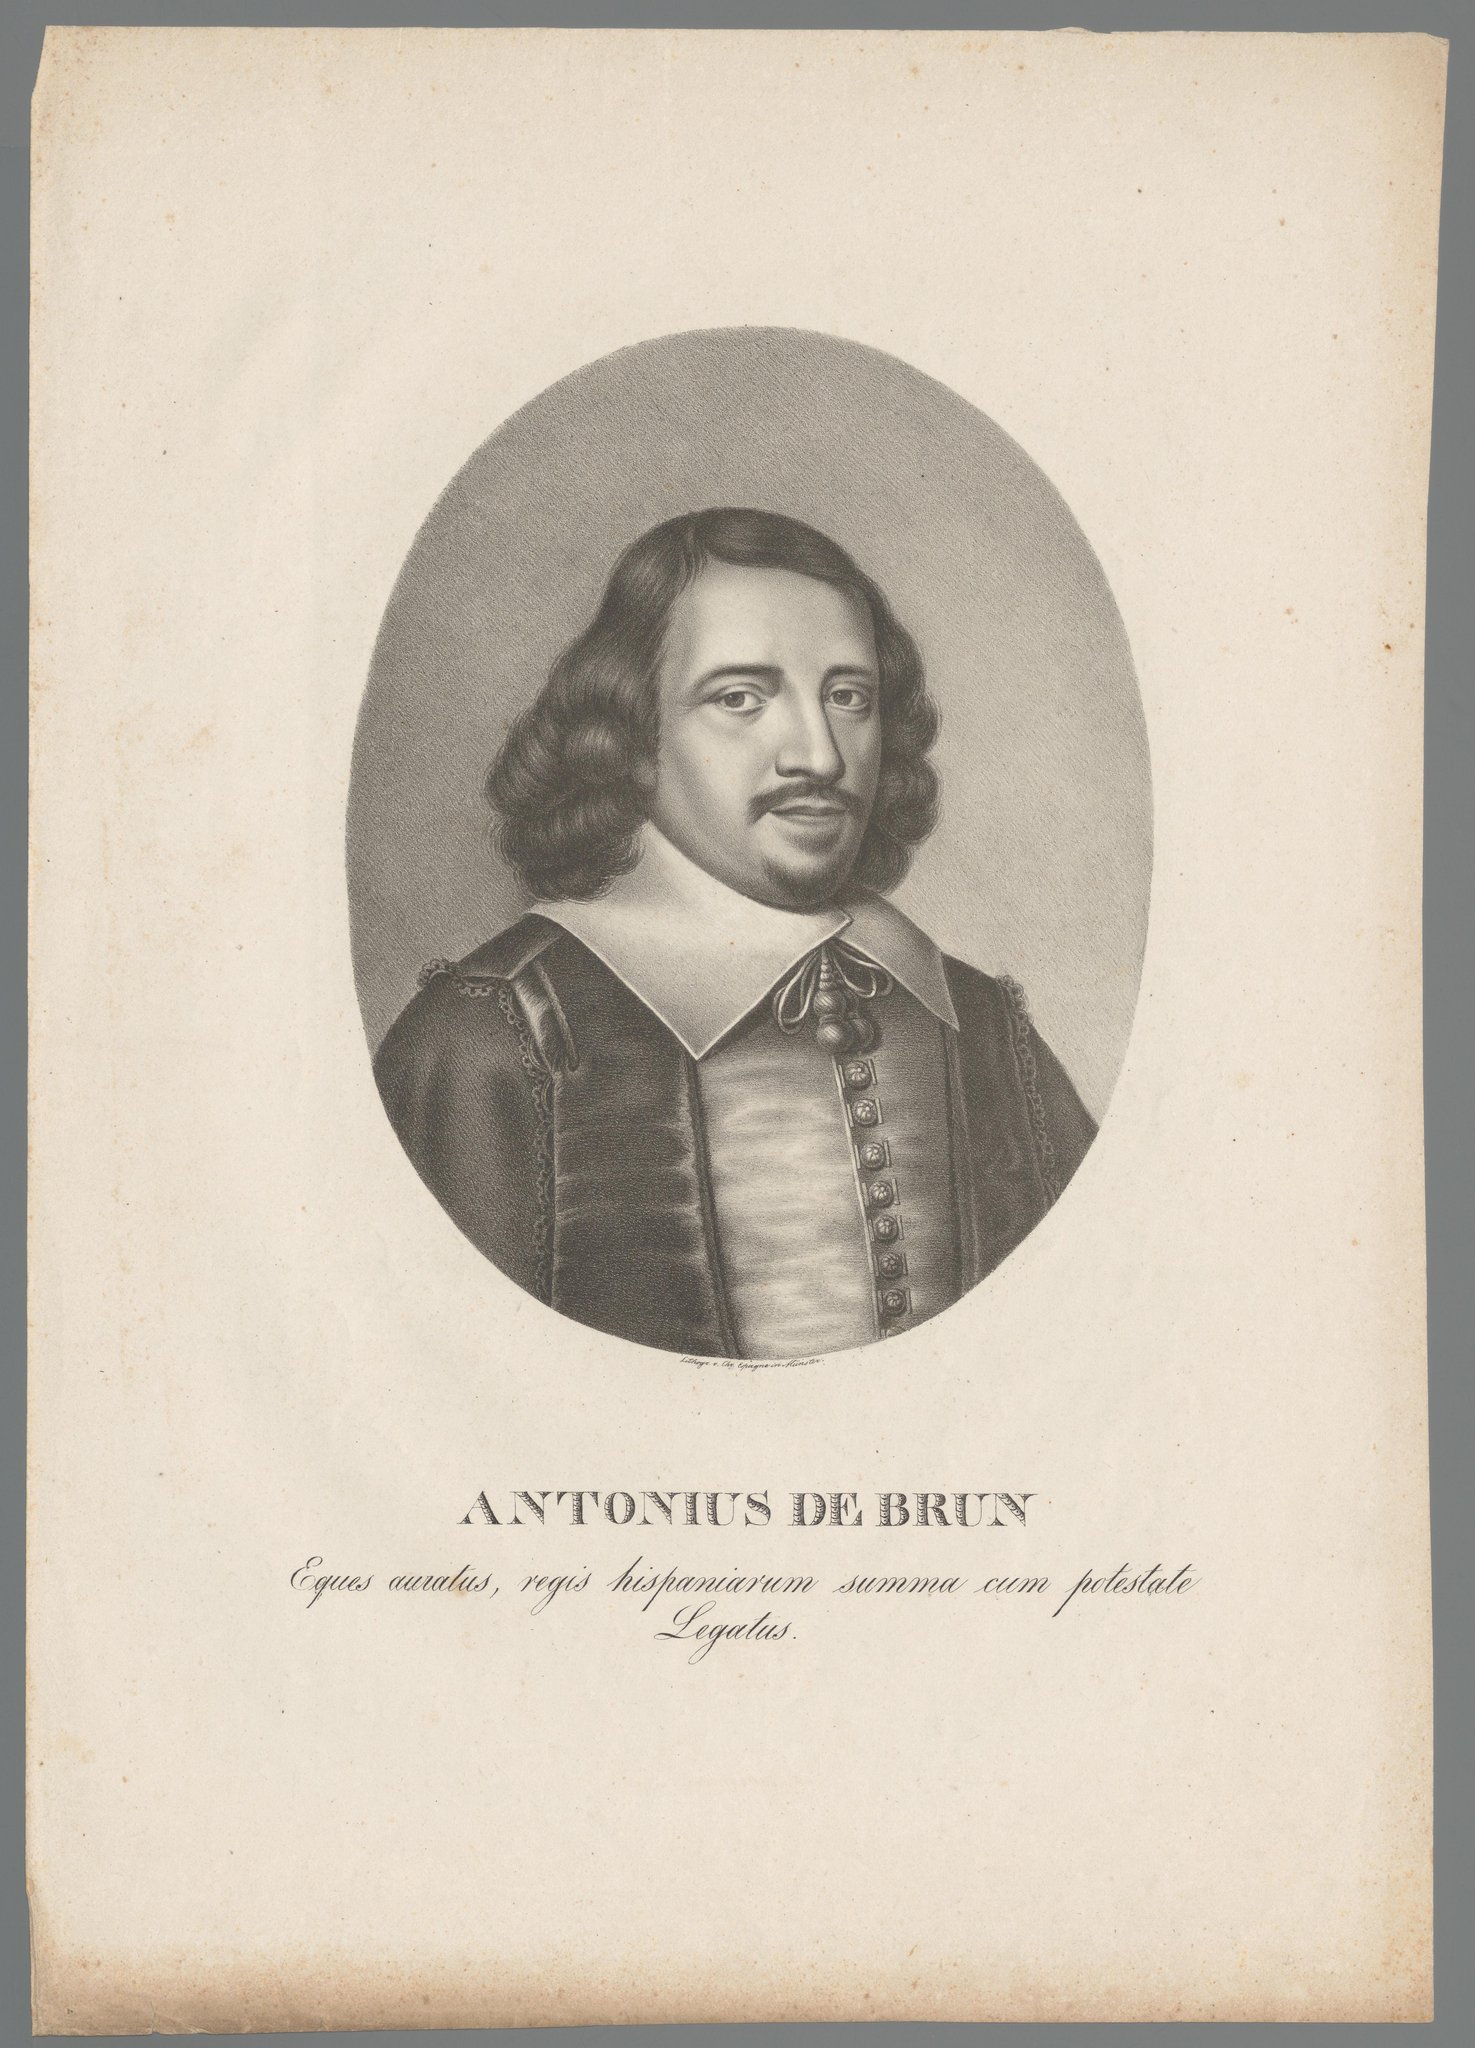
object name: print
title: Portret van Antoine Brun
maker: christian espagne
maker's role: print maker, printer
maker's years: 1794-1838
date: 1824-1827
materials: paper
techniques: lithograph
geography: munster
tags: moustache, adult man, historical persons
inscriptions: collector's mark: Lugt 2228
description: Prent uit: Bildnisse der beim westfälischen Friedensschluß zu Münster und Osnabrück versammelt gewesenen Gesandten. Münster: Christian Espagne, [1824-1827]. Deze publicatie bevat een onbekend aantal lithografieën, die in afleveringen verschenen als illustratie bij de tekst.